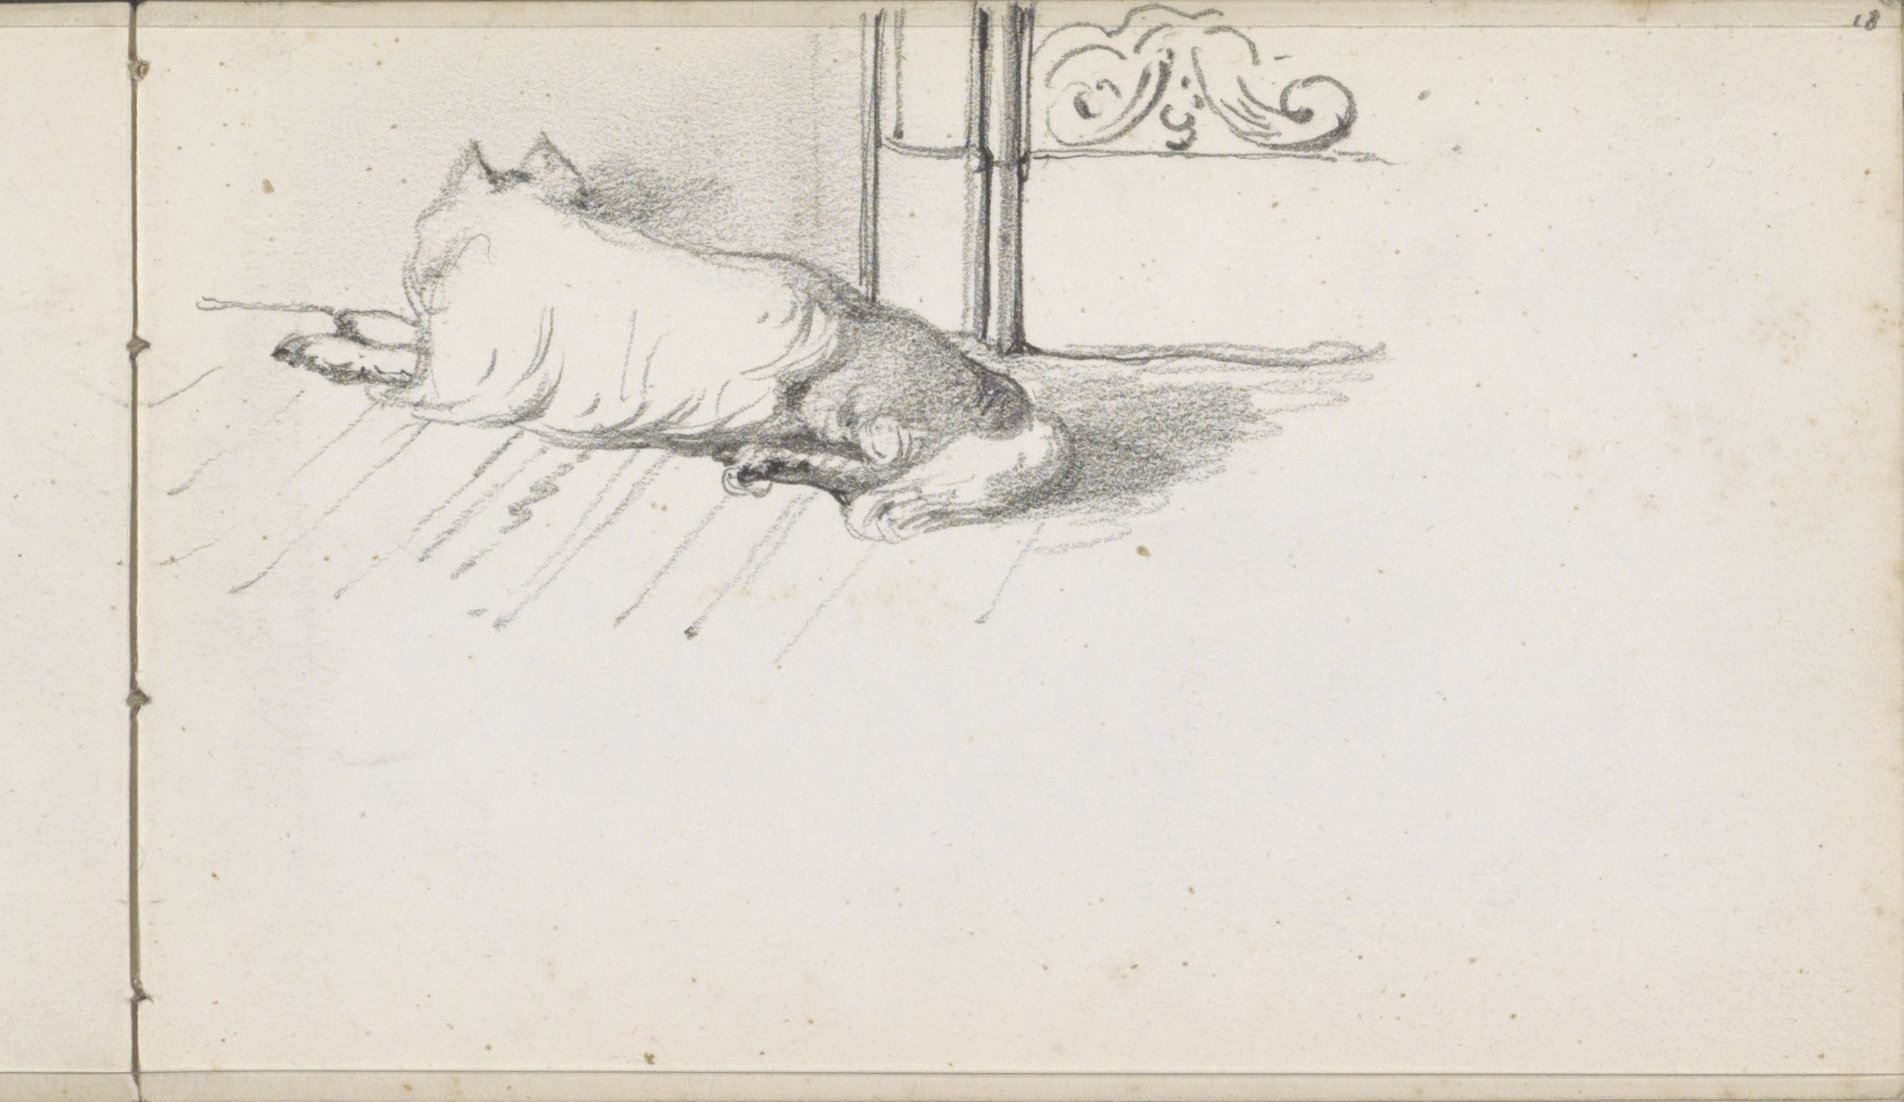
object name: sketchbook leaf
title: Hond liggend bij een deurpost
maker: maria vos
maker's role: draughtsman, painter, print maker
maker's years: 1824-1906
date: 1863-1864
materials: paper, pencil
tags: dog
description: Blad 18 recto uit een schetsboek met 41 bladen.